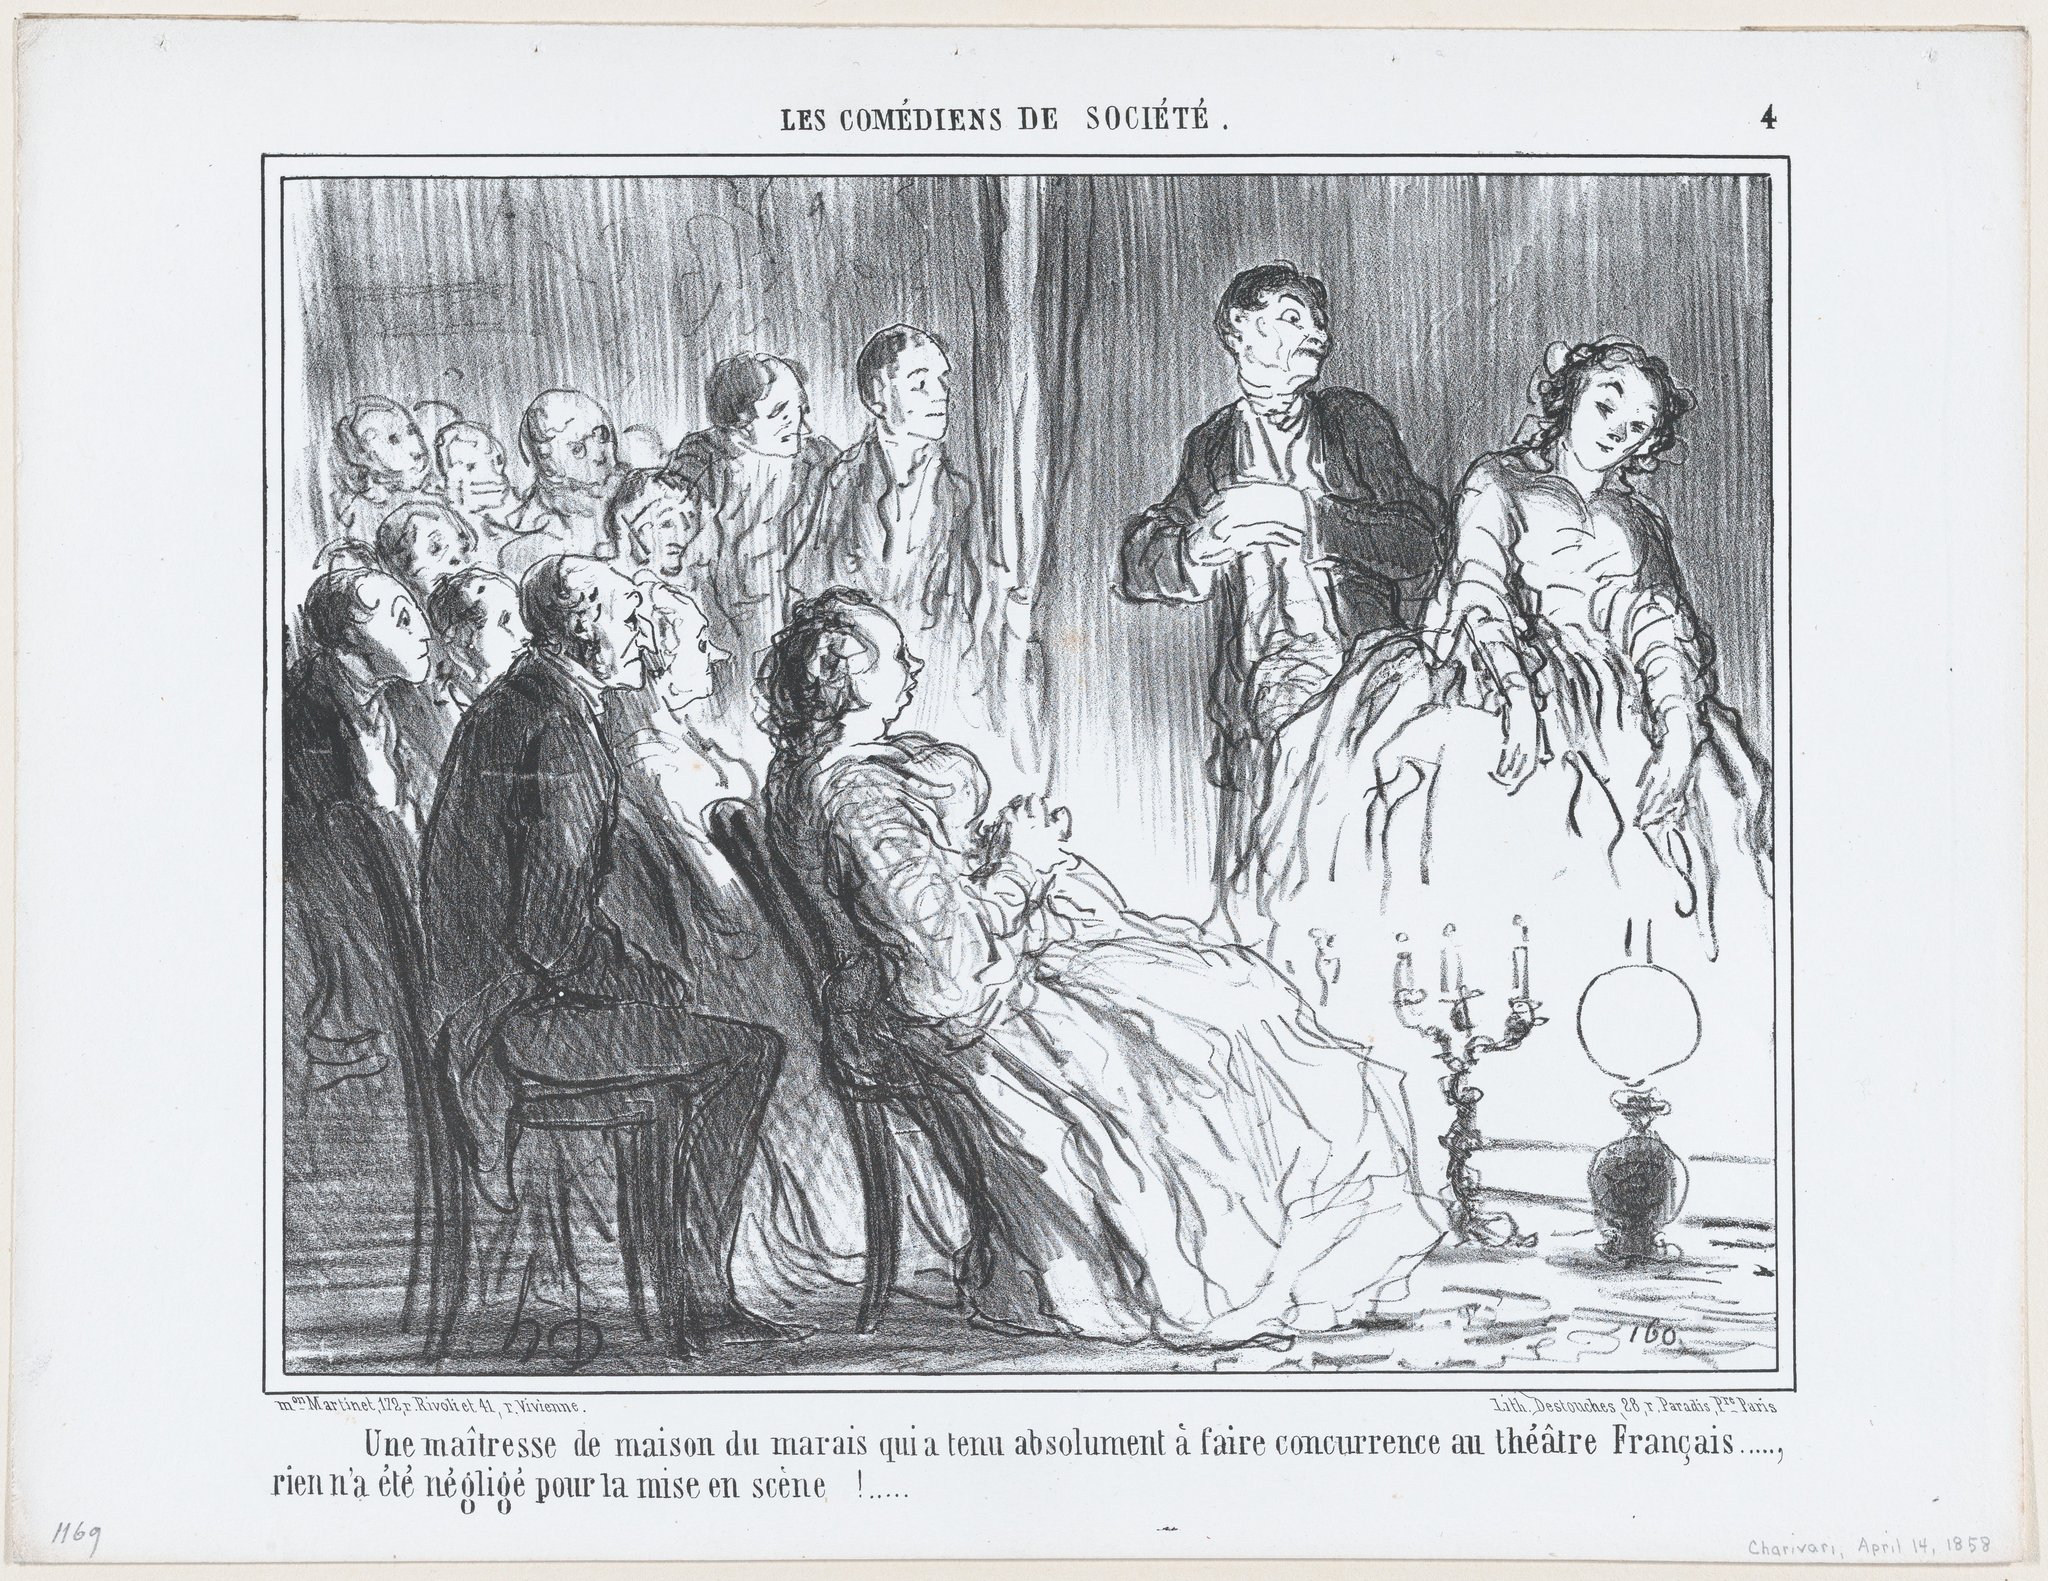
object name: print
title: Une maîtresse de maison du marais..., from Les Comédiens de Société, published in "Le Charivari"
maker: honoré daumier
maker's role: artist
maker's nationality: french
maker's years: 1808-1879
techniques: lithograph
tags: men,women